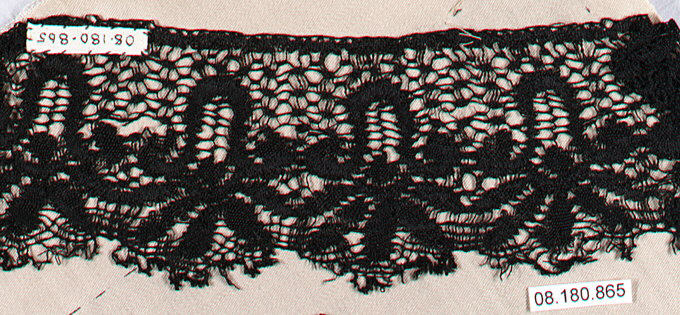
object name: piece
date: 1801-1900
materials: silk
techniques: lace